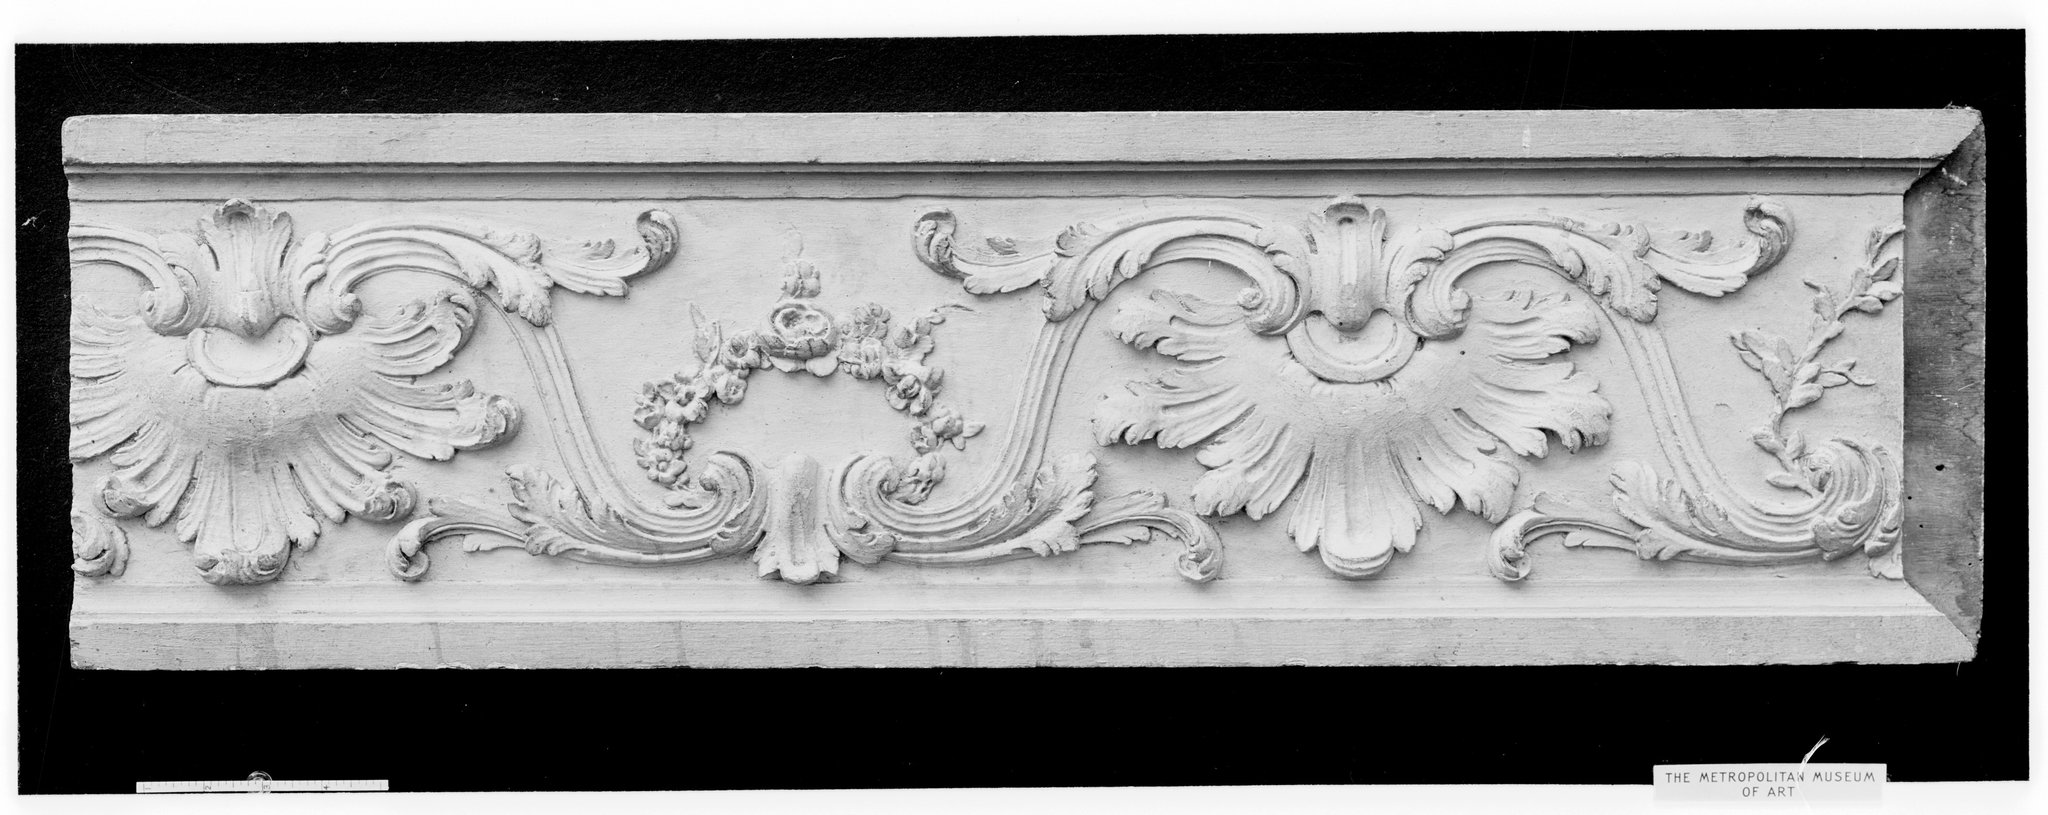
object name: frieze fragment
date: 1667-1733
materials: wood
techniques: painting